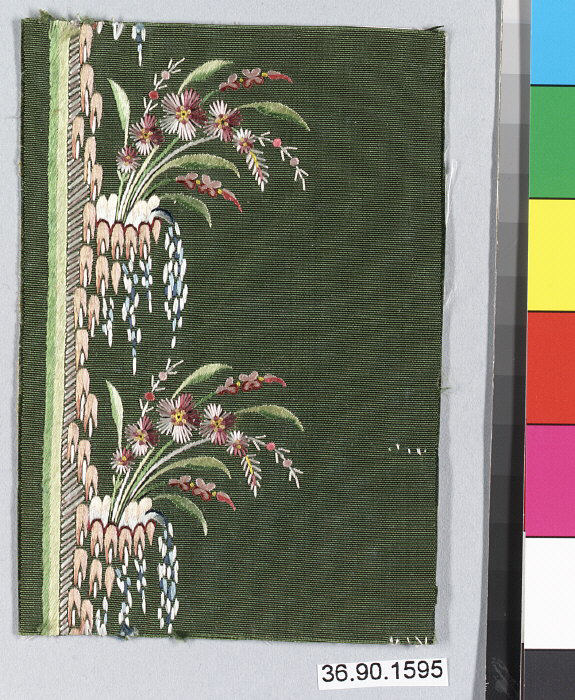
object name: sample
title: Embroidery sample for a man’s suit or waistcoat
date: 1785-1815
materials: silk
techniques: embroidery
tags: flowers